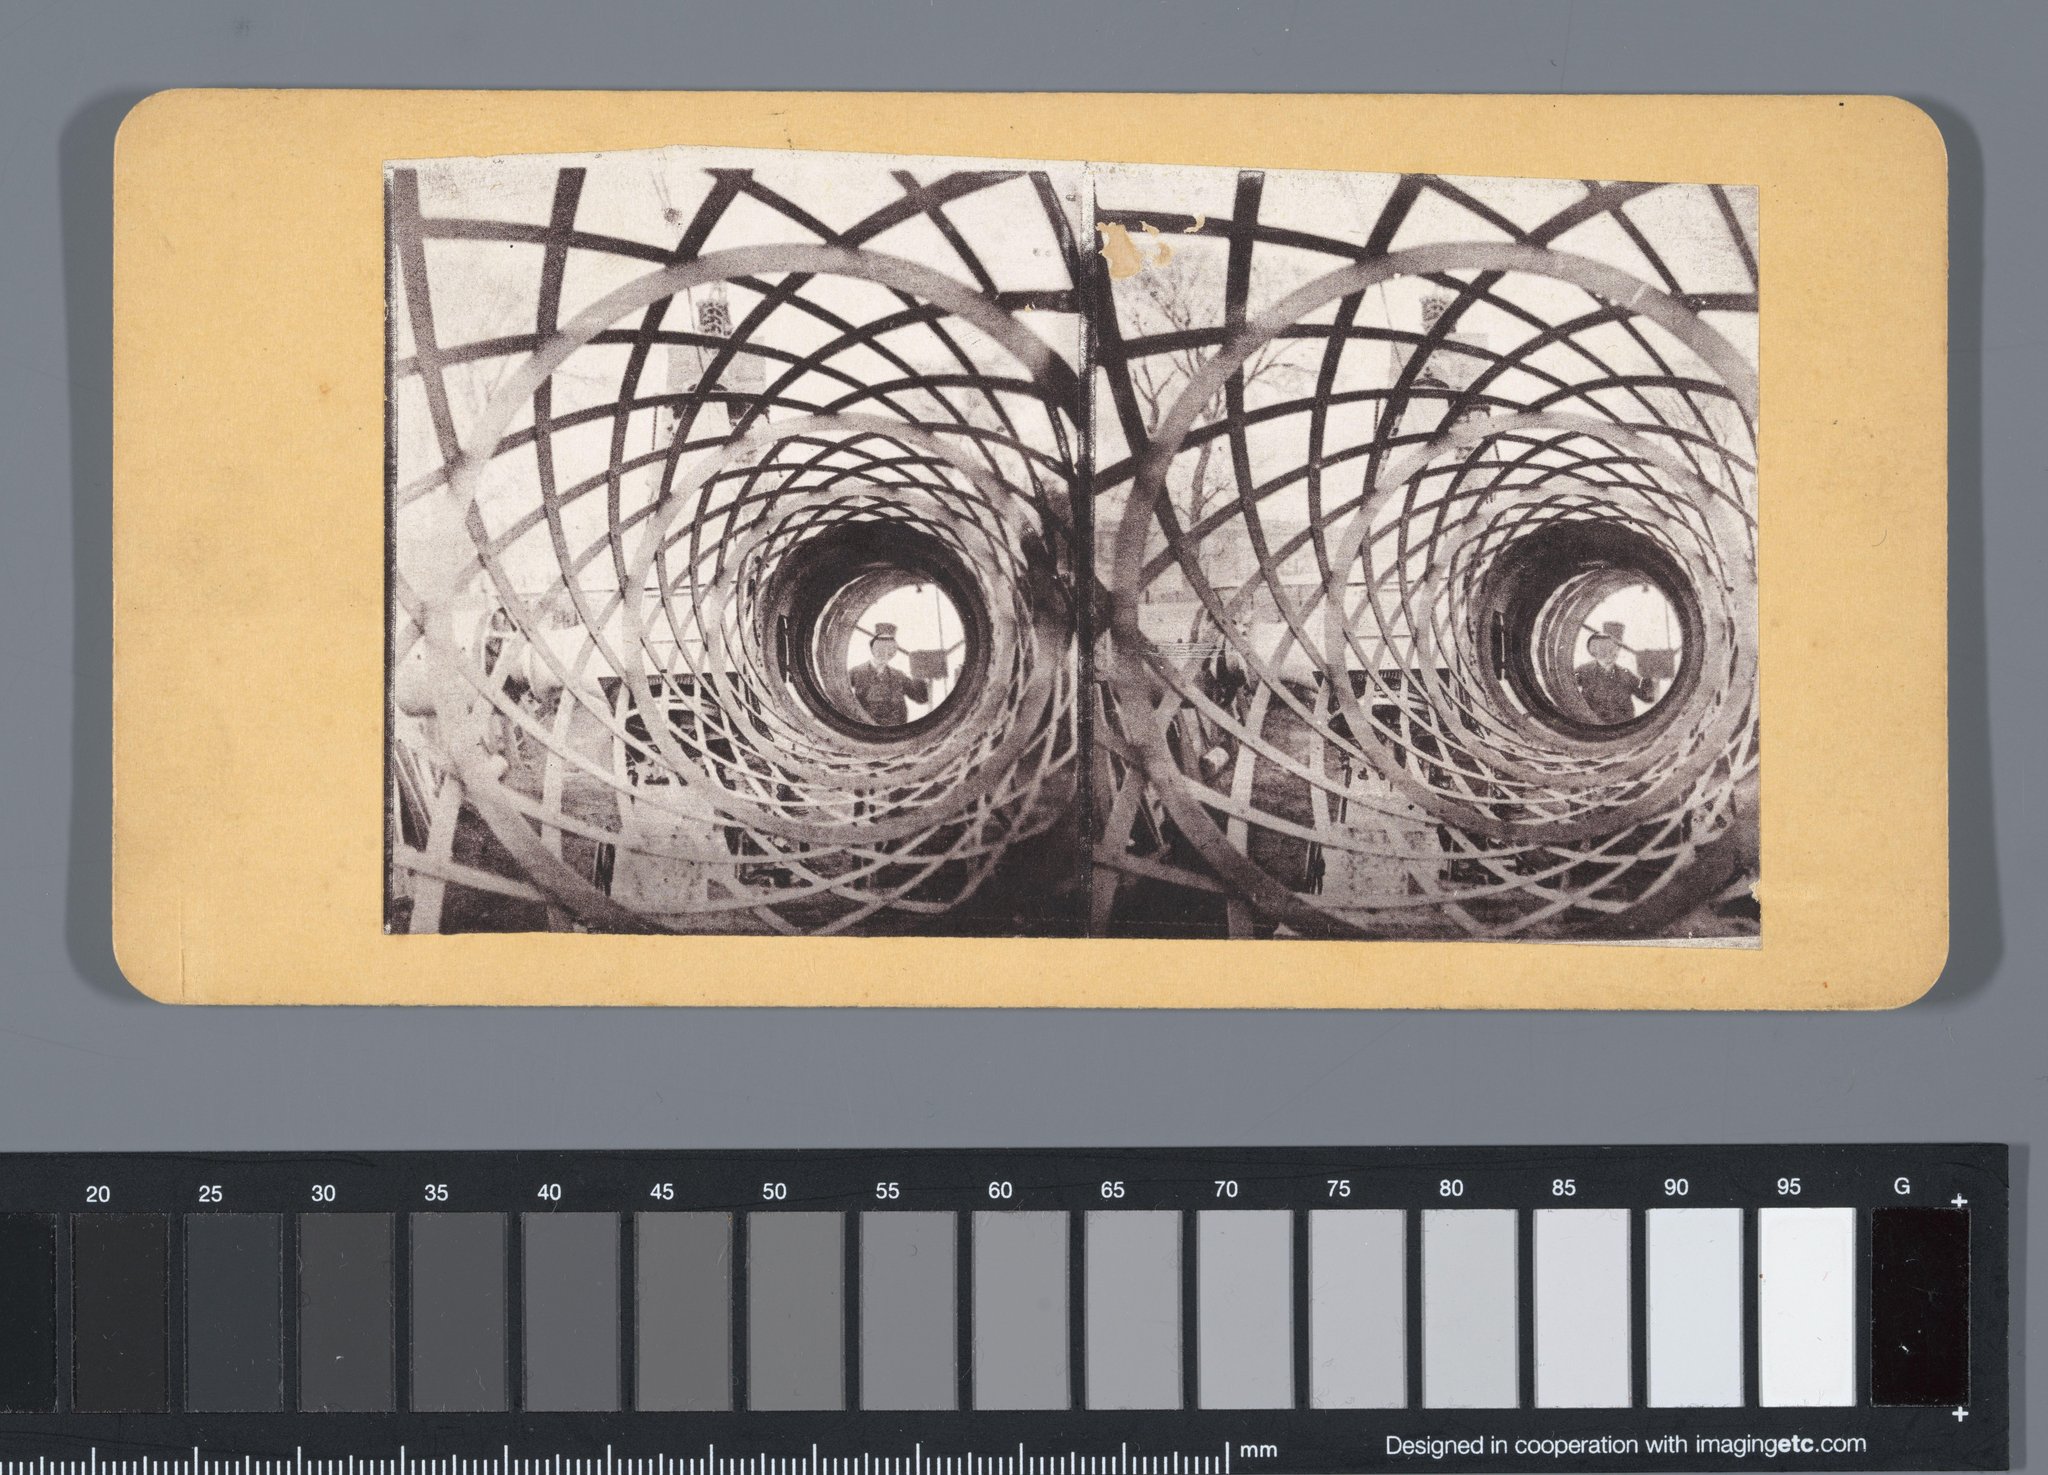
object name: stereograph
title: Doorkijk in open metalen koker, waarvan aan het uiteinde een man staat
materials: cardboard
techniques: photograph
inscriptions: stamp: ‘P.H.J. Reynet de la Rue Amsterdam, Utrechtschestraat 35 Kunsthandel Phot. Inrichting’